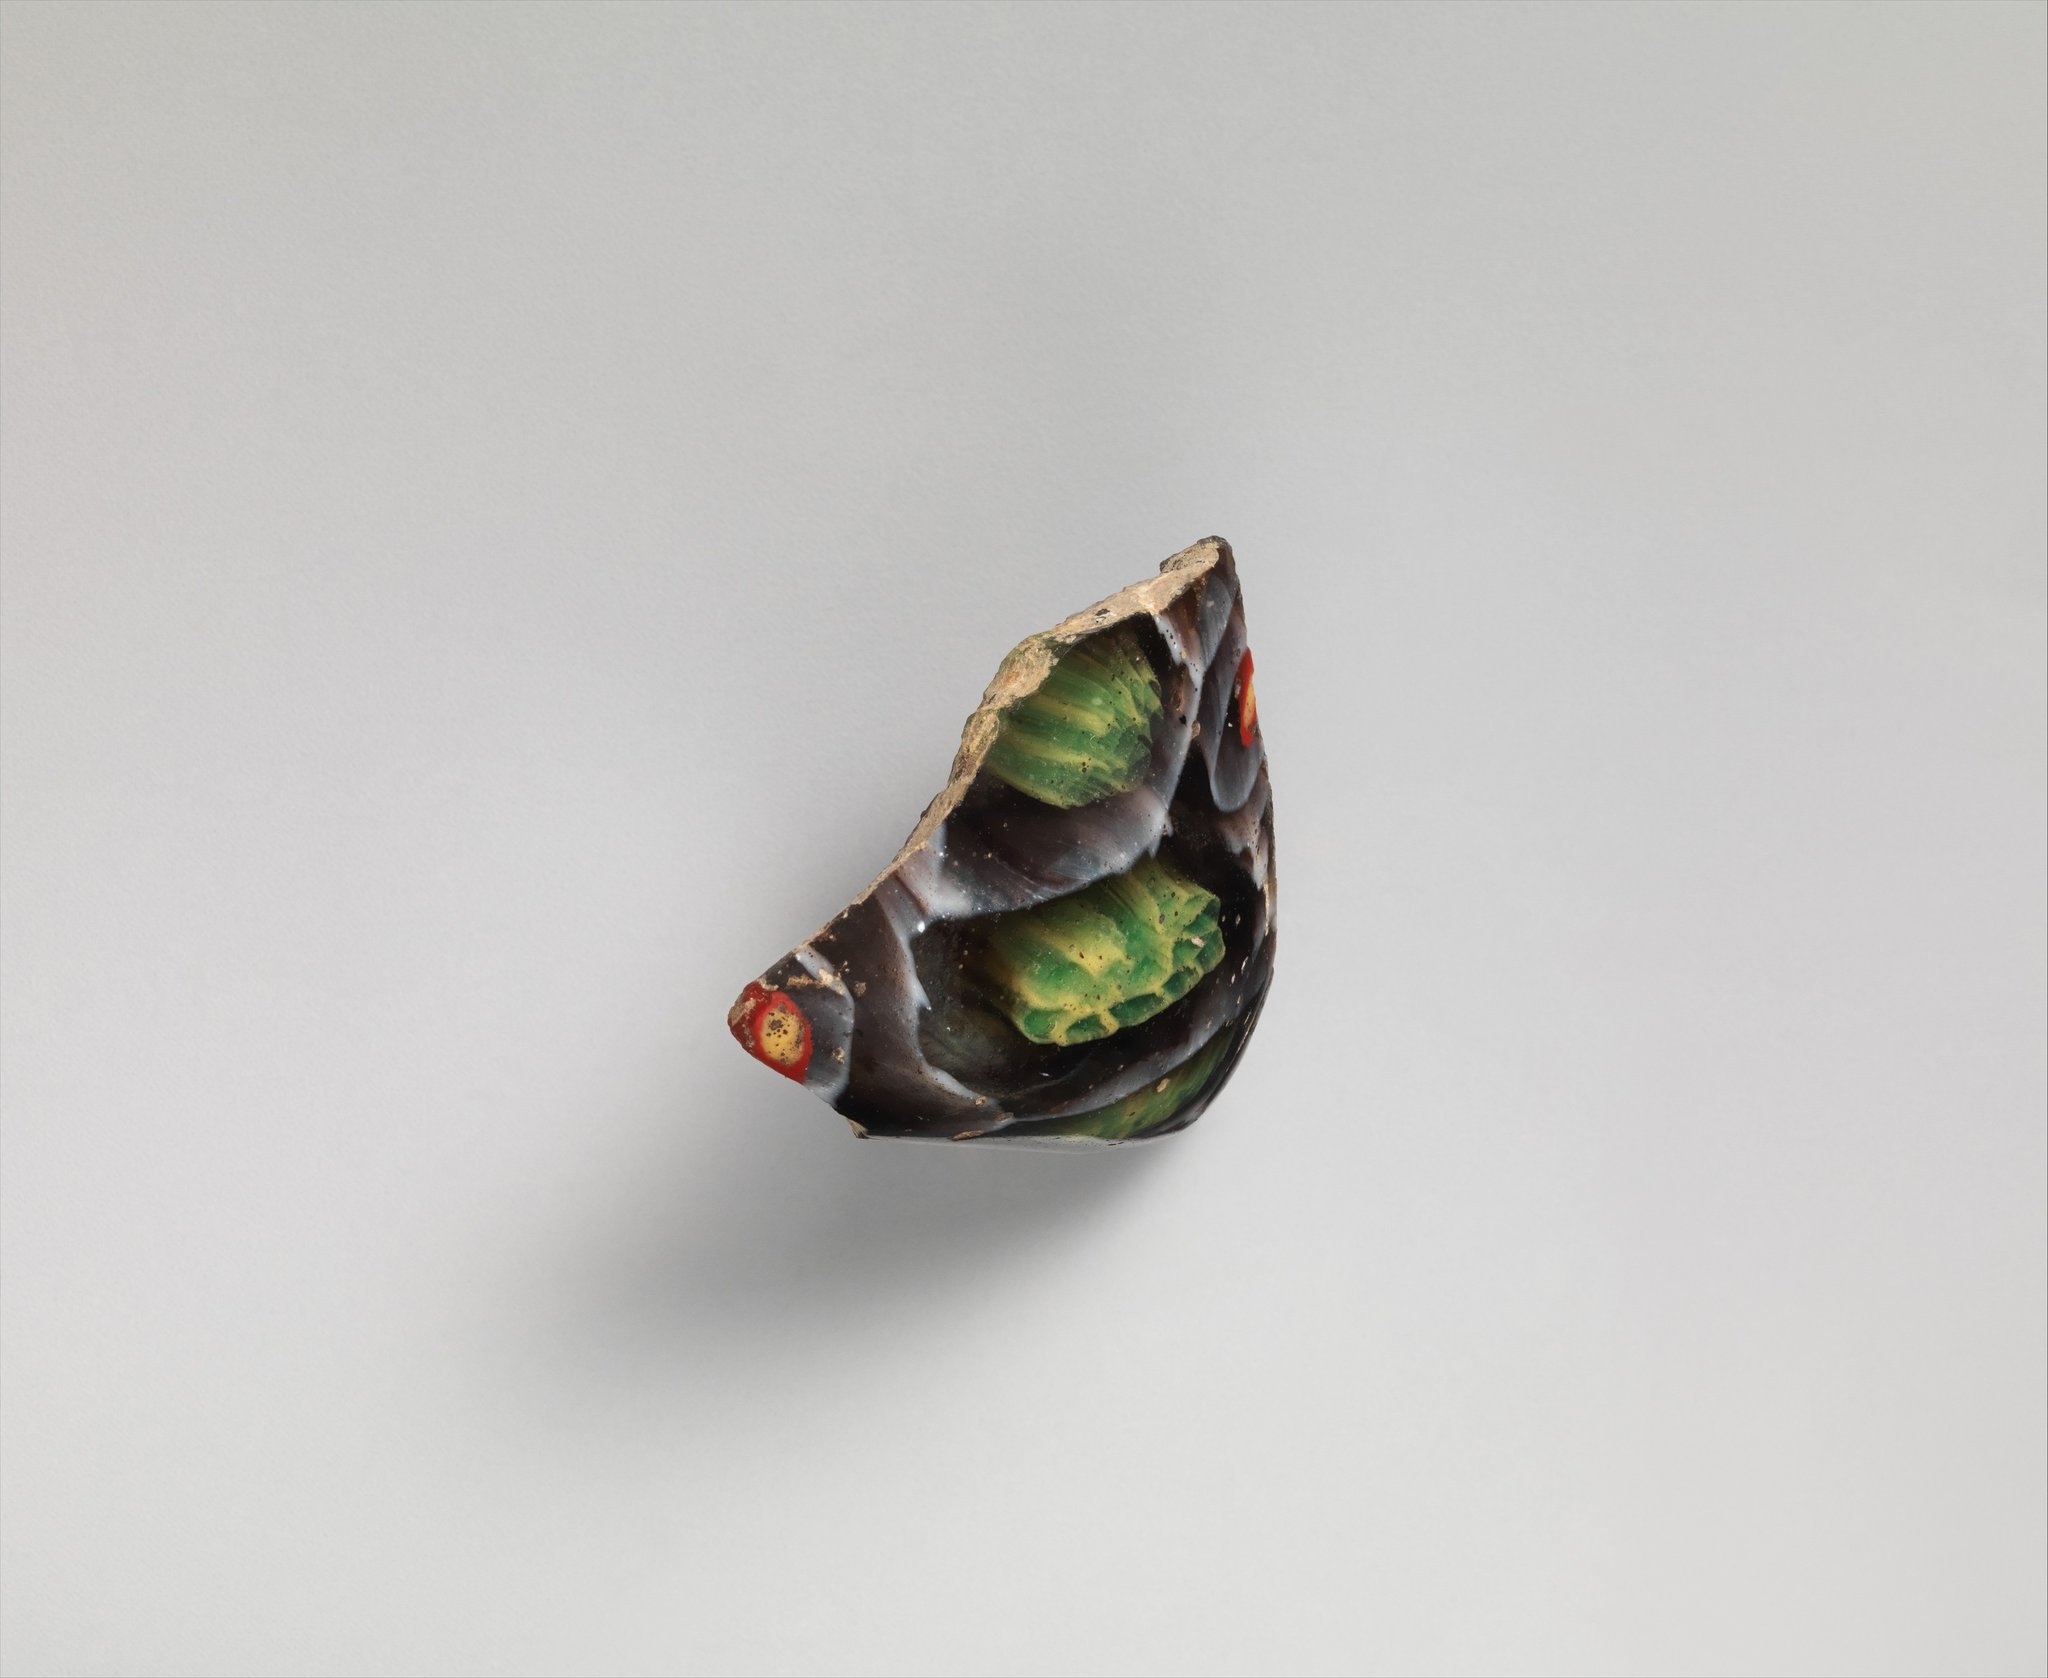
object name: fragment, mosaic box pyxis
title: Glass mosaic box (pyxis) fragment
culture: roman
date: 34 BCE-33 CE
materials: glass